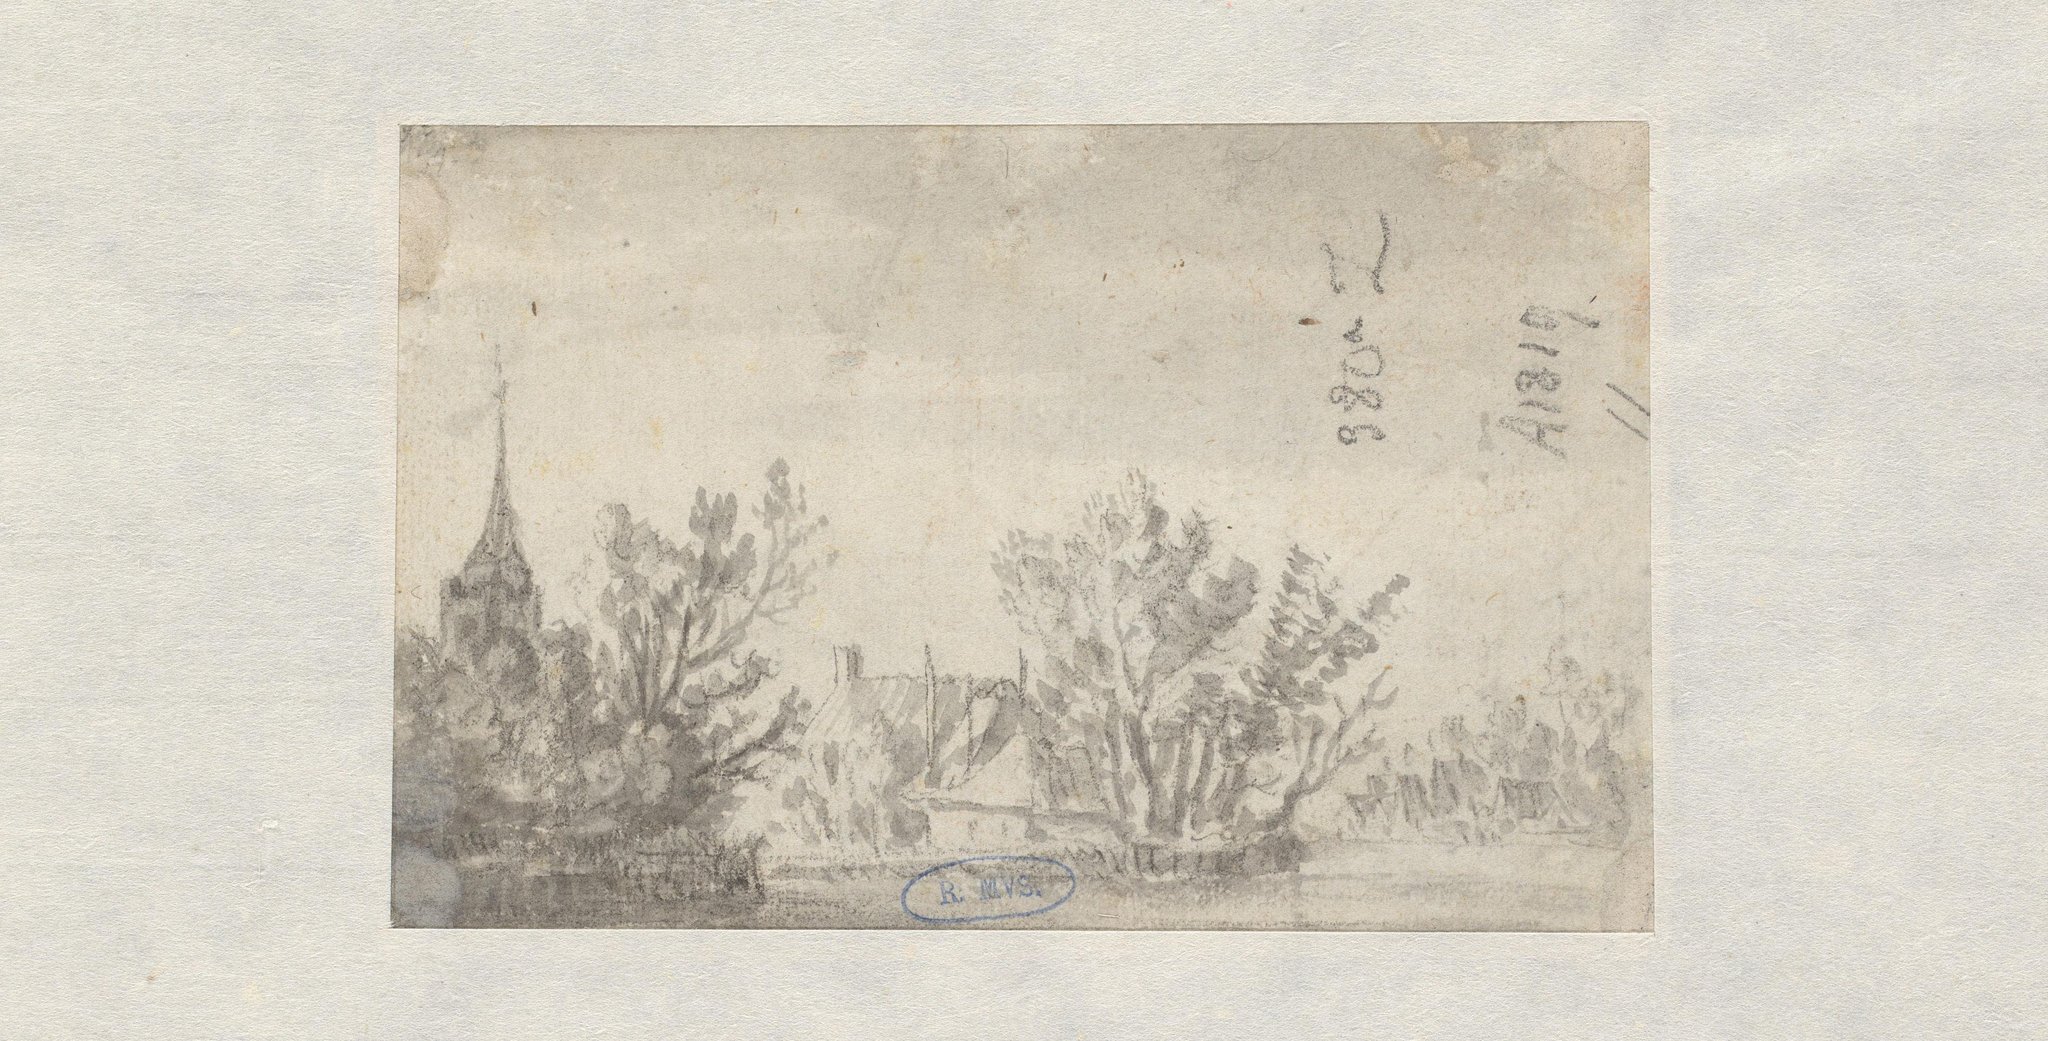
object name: drawing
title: Dorpsgezicht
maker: anthonie waterloo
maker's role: draughtsman, painter, print maker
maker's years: 1609-1690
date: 1619-1690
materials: chalk, paper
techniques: brush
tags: prospect of village, silhouette of village